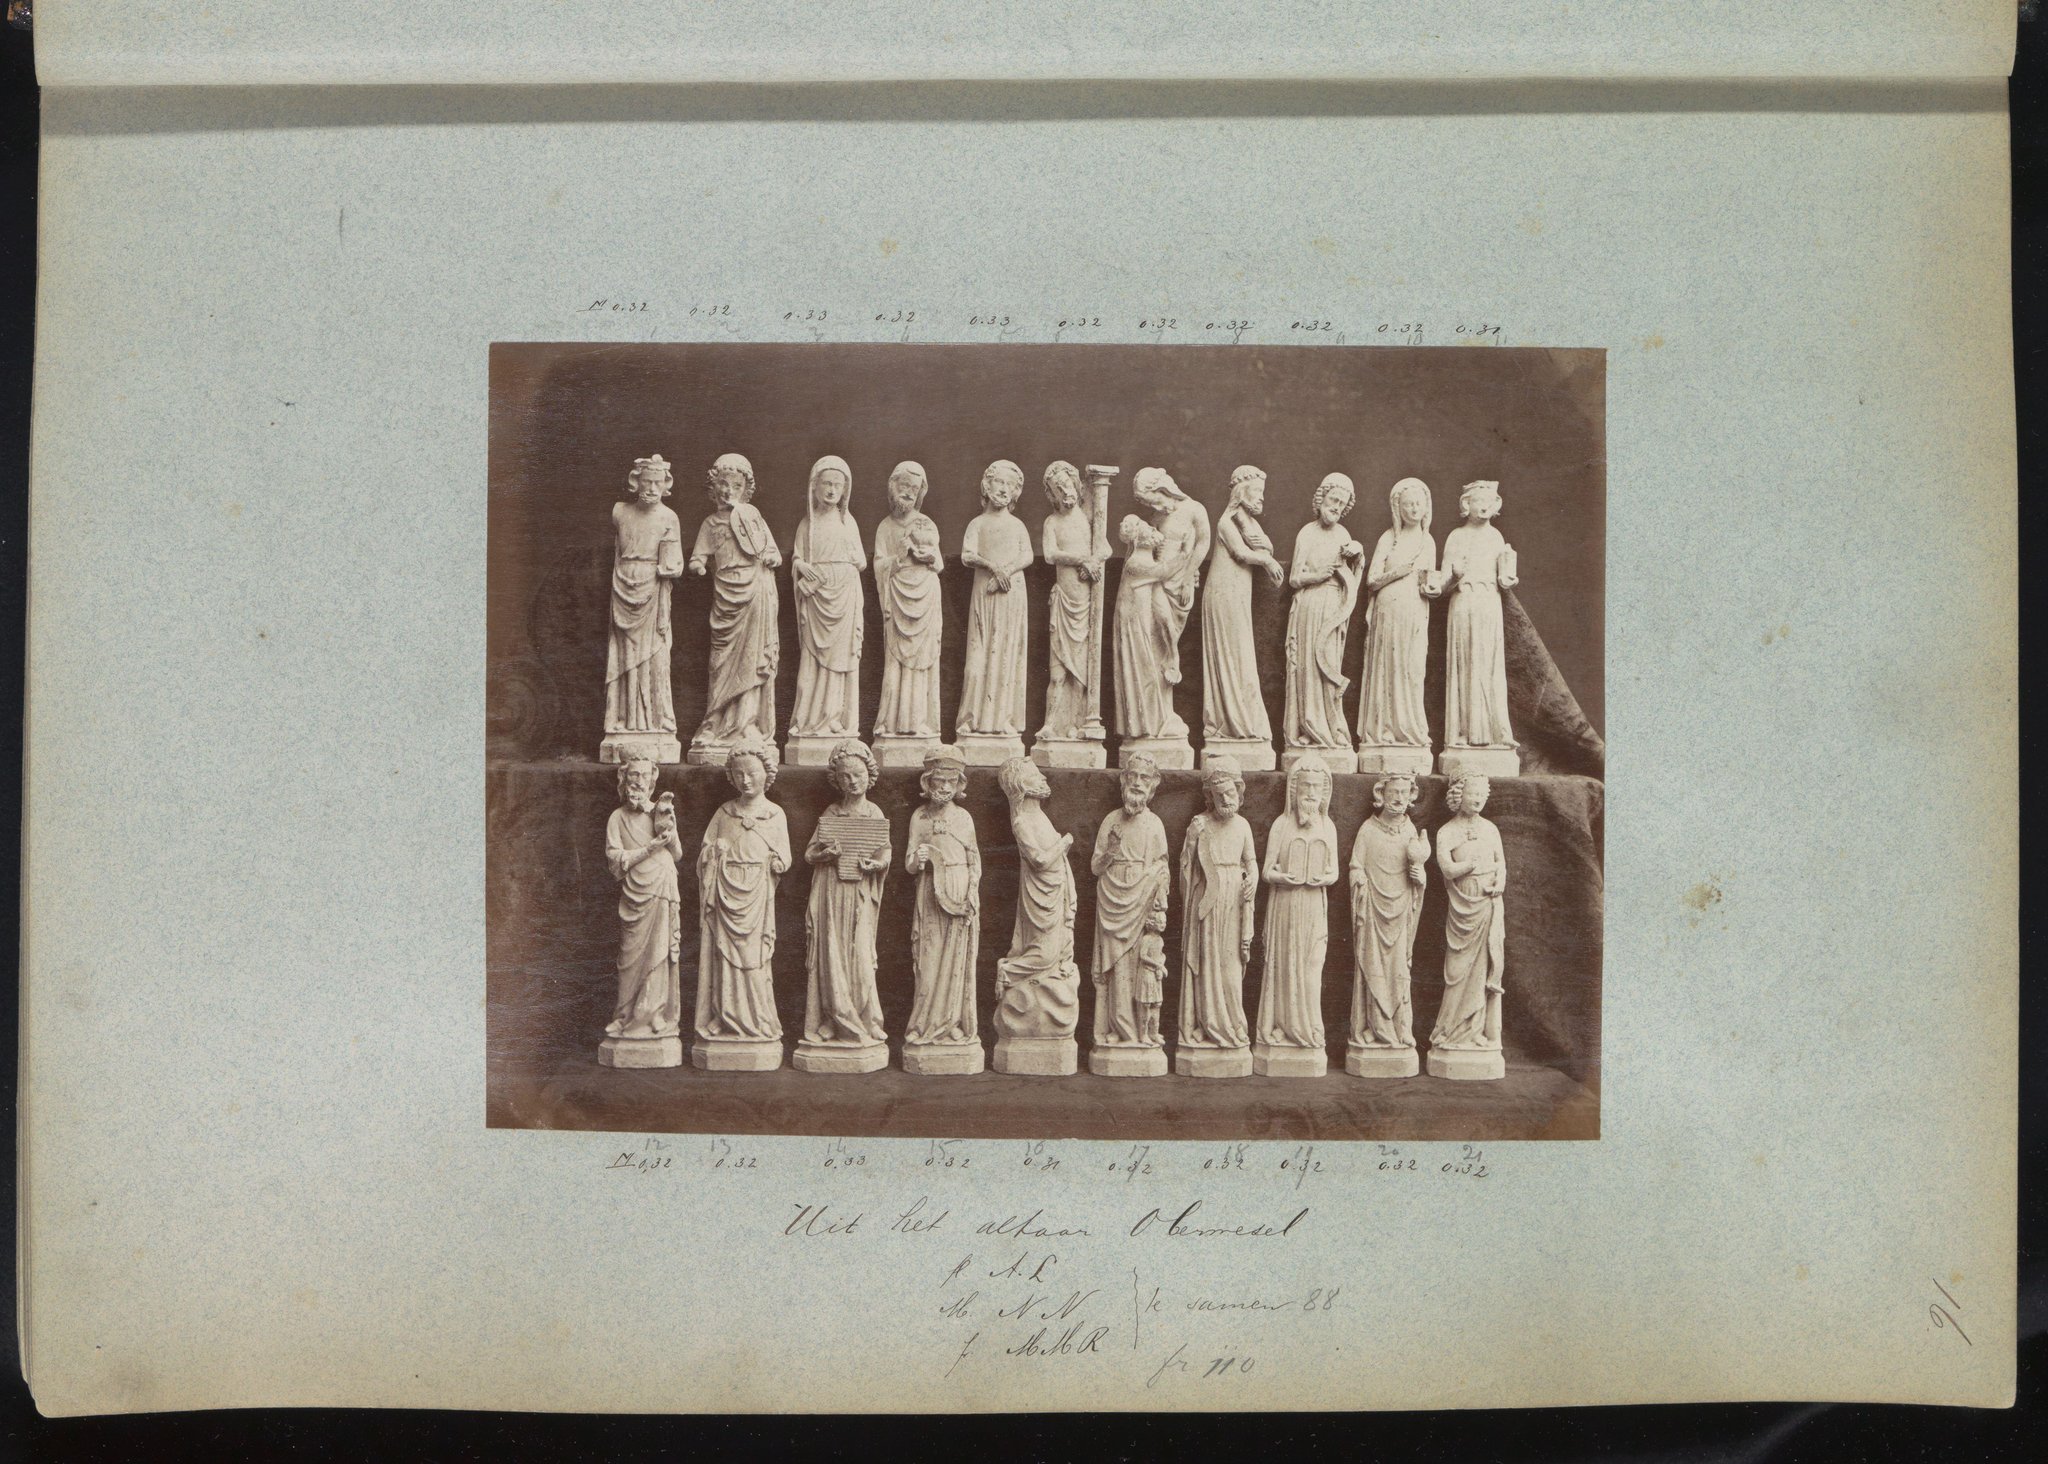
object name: album leaf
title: Gipsen afgietsels van sculpturen van een altaar uit Oberwesel te Duitsland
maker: Anonymous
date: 1875-1900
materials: paper, photographic support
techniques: albumen print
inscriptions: annotation, annotation: ‘Uit het altaar Oberwesel’